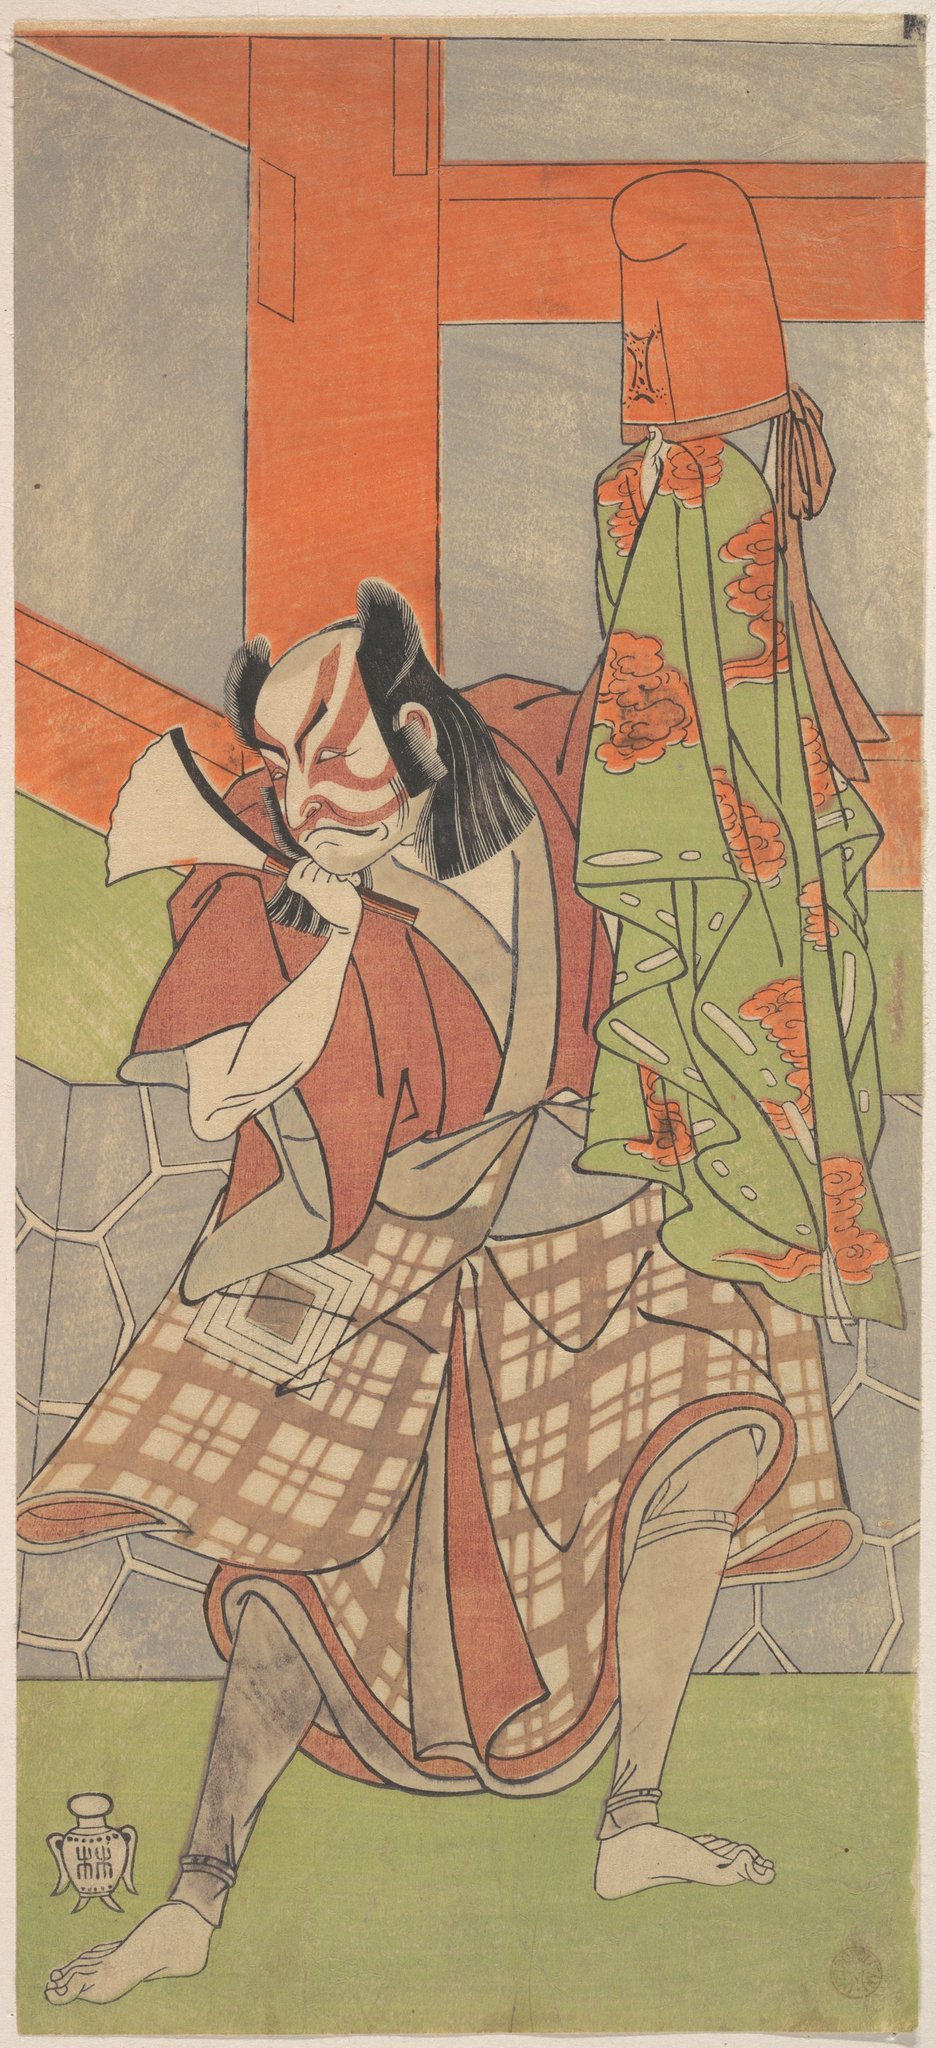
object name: woodblock print nishiki e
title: The Fourth Ichikawa Danjuro in the Role of Yahei-byoe Munekiyo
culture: japanese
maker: katsukawa shunshō 勝川春章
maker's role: artist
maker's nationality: japanese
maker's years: 1726-1792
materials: ink, paper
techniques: nishiki e, woodblock print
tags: men,actors